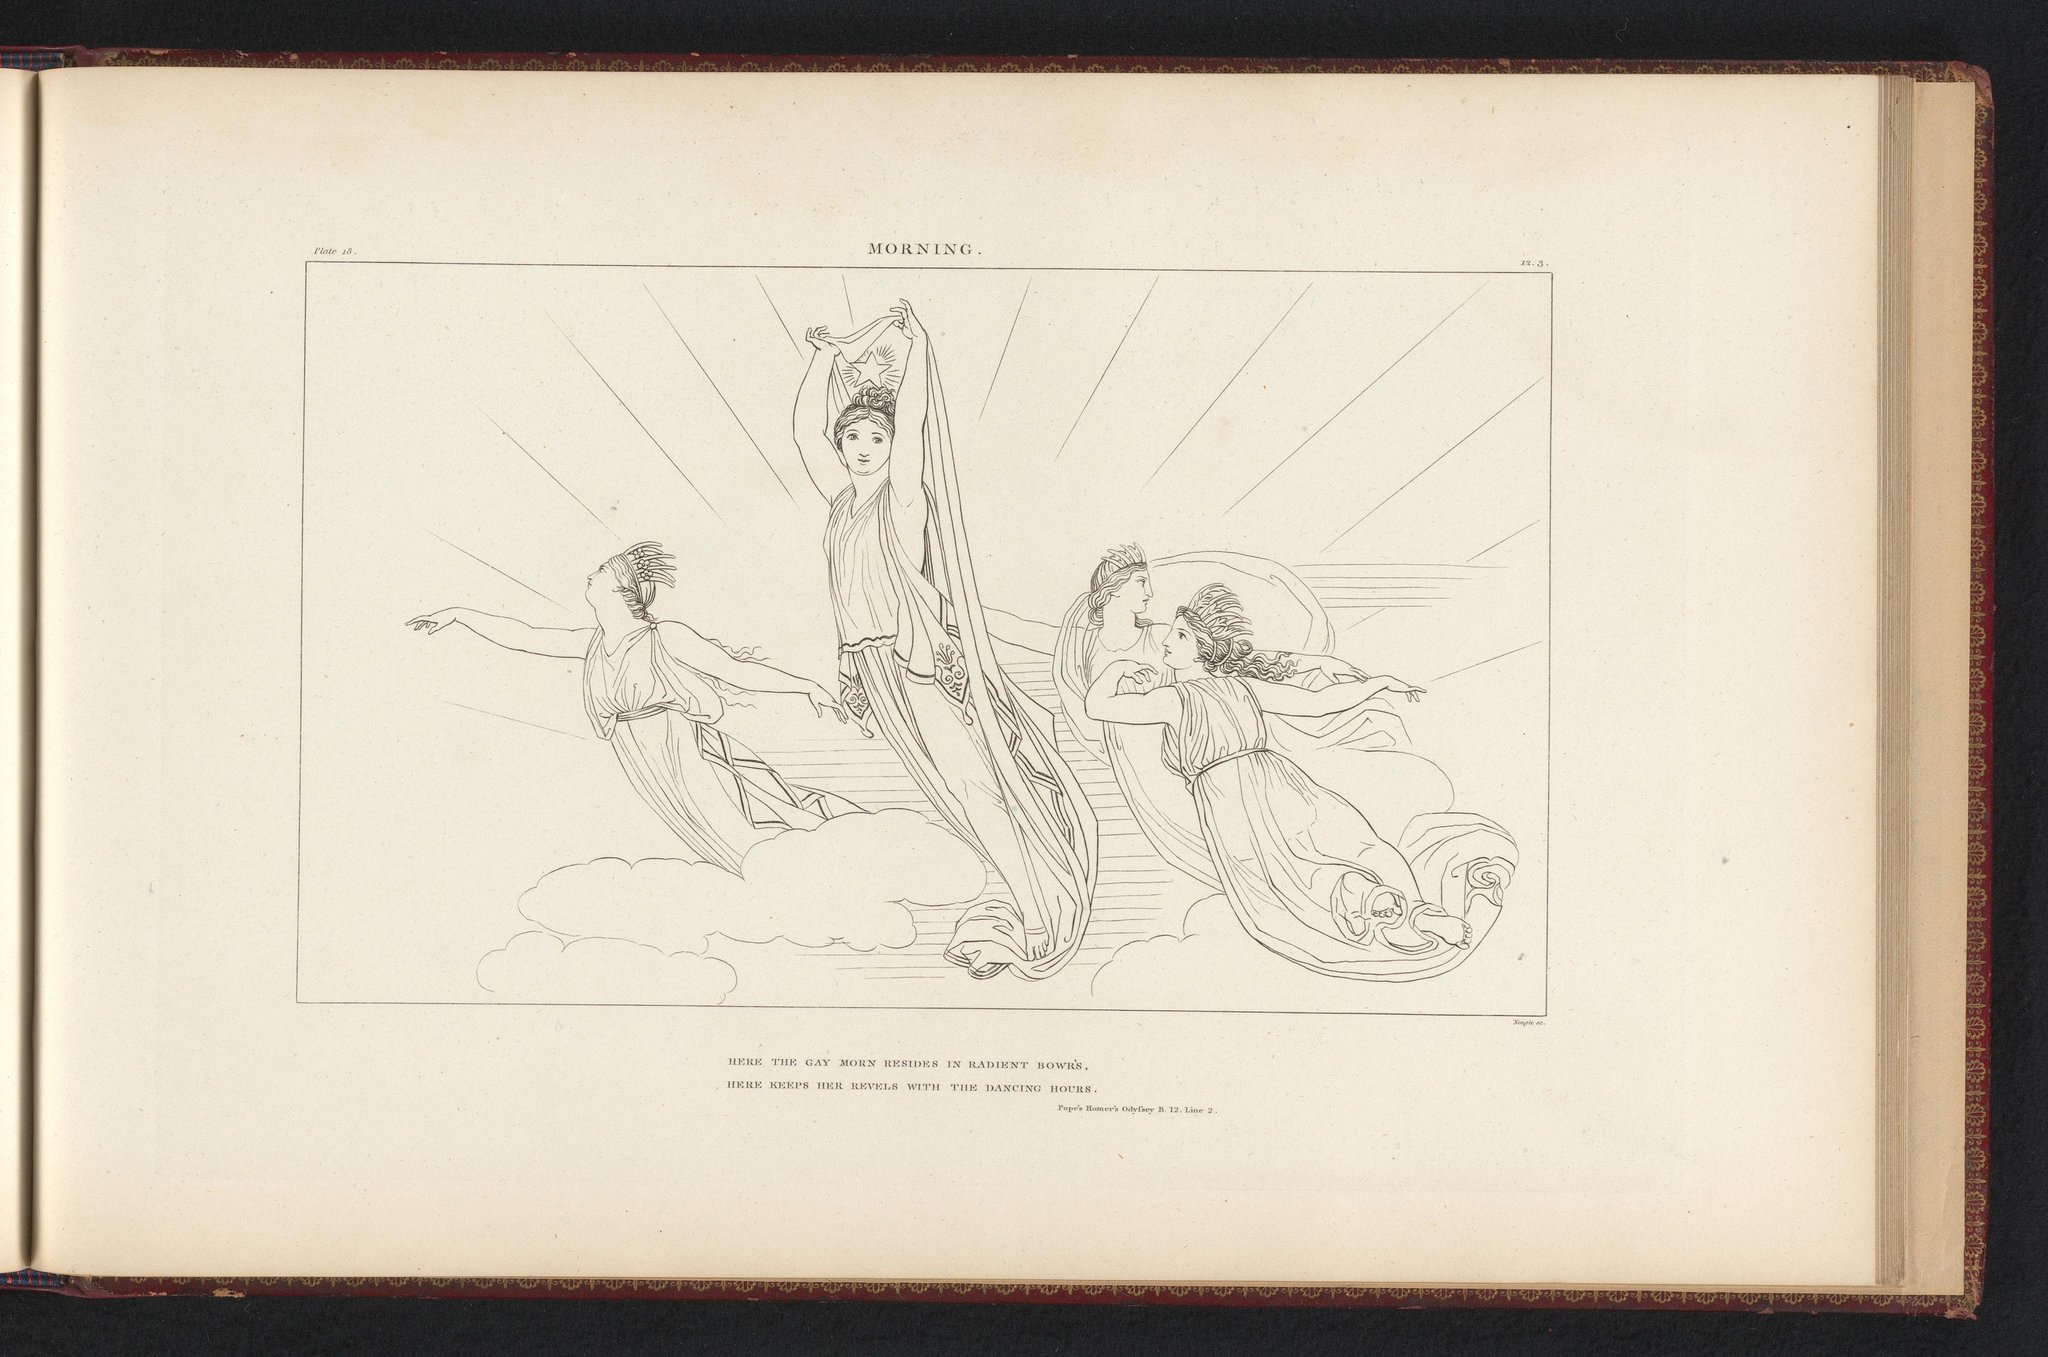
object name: print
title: Morning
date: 1805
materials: paper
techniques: etching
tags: personification of the morning, 'aurora'; 'aurora' (ripa)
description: Prent maakt onderdeel uit van een serie met 34 prenten over de Odyssee, geschreven door Homerus.